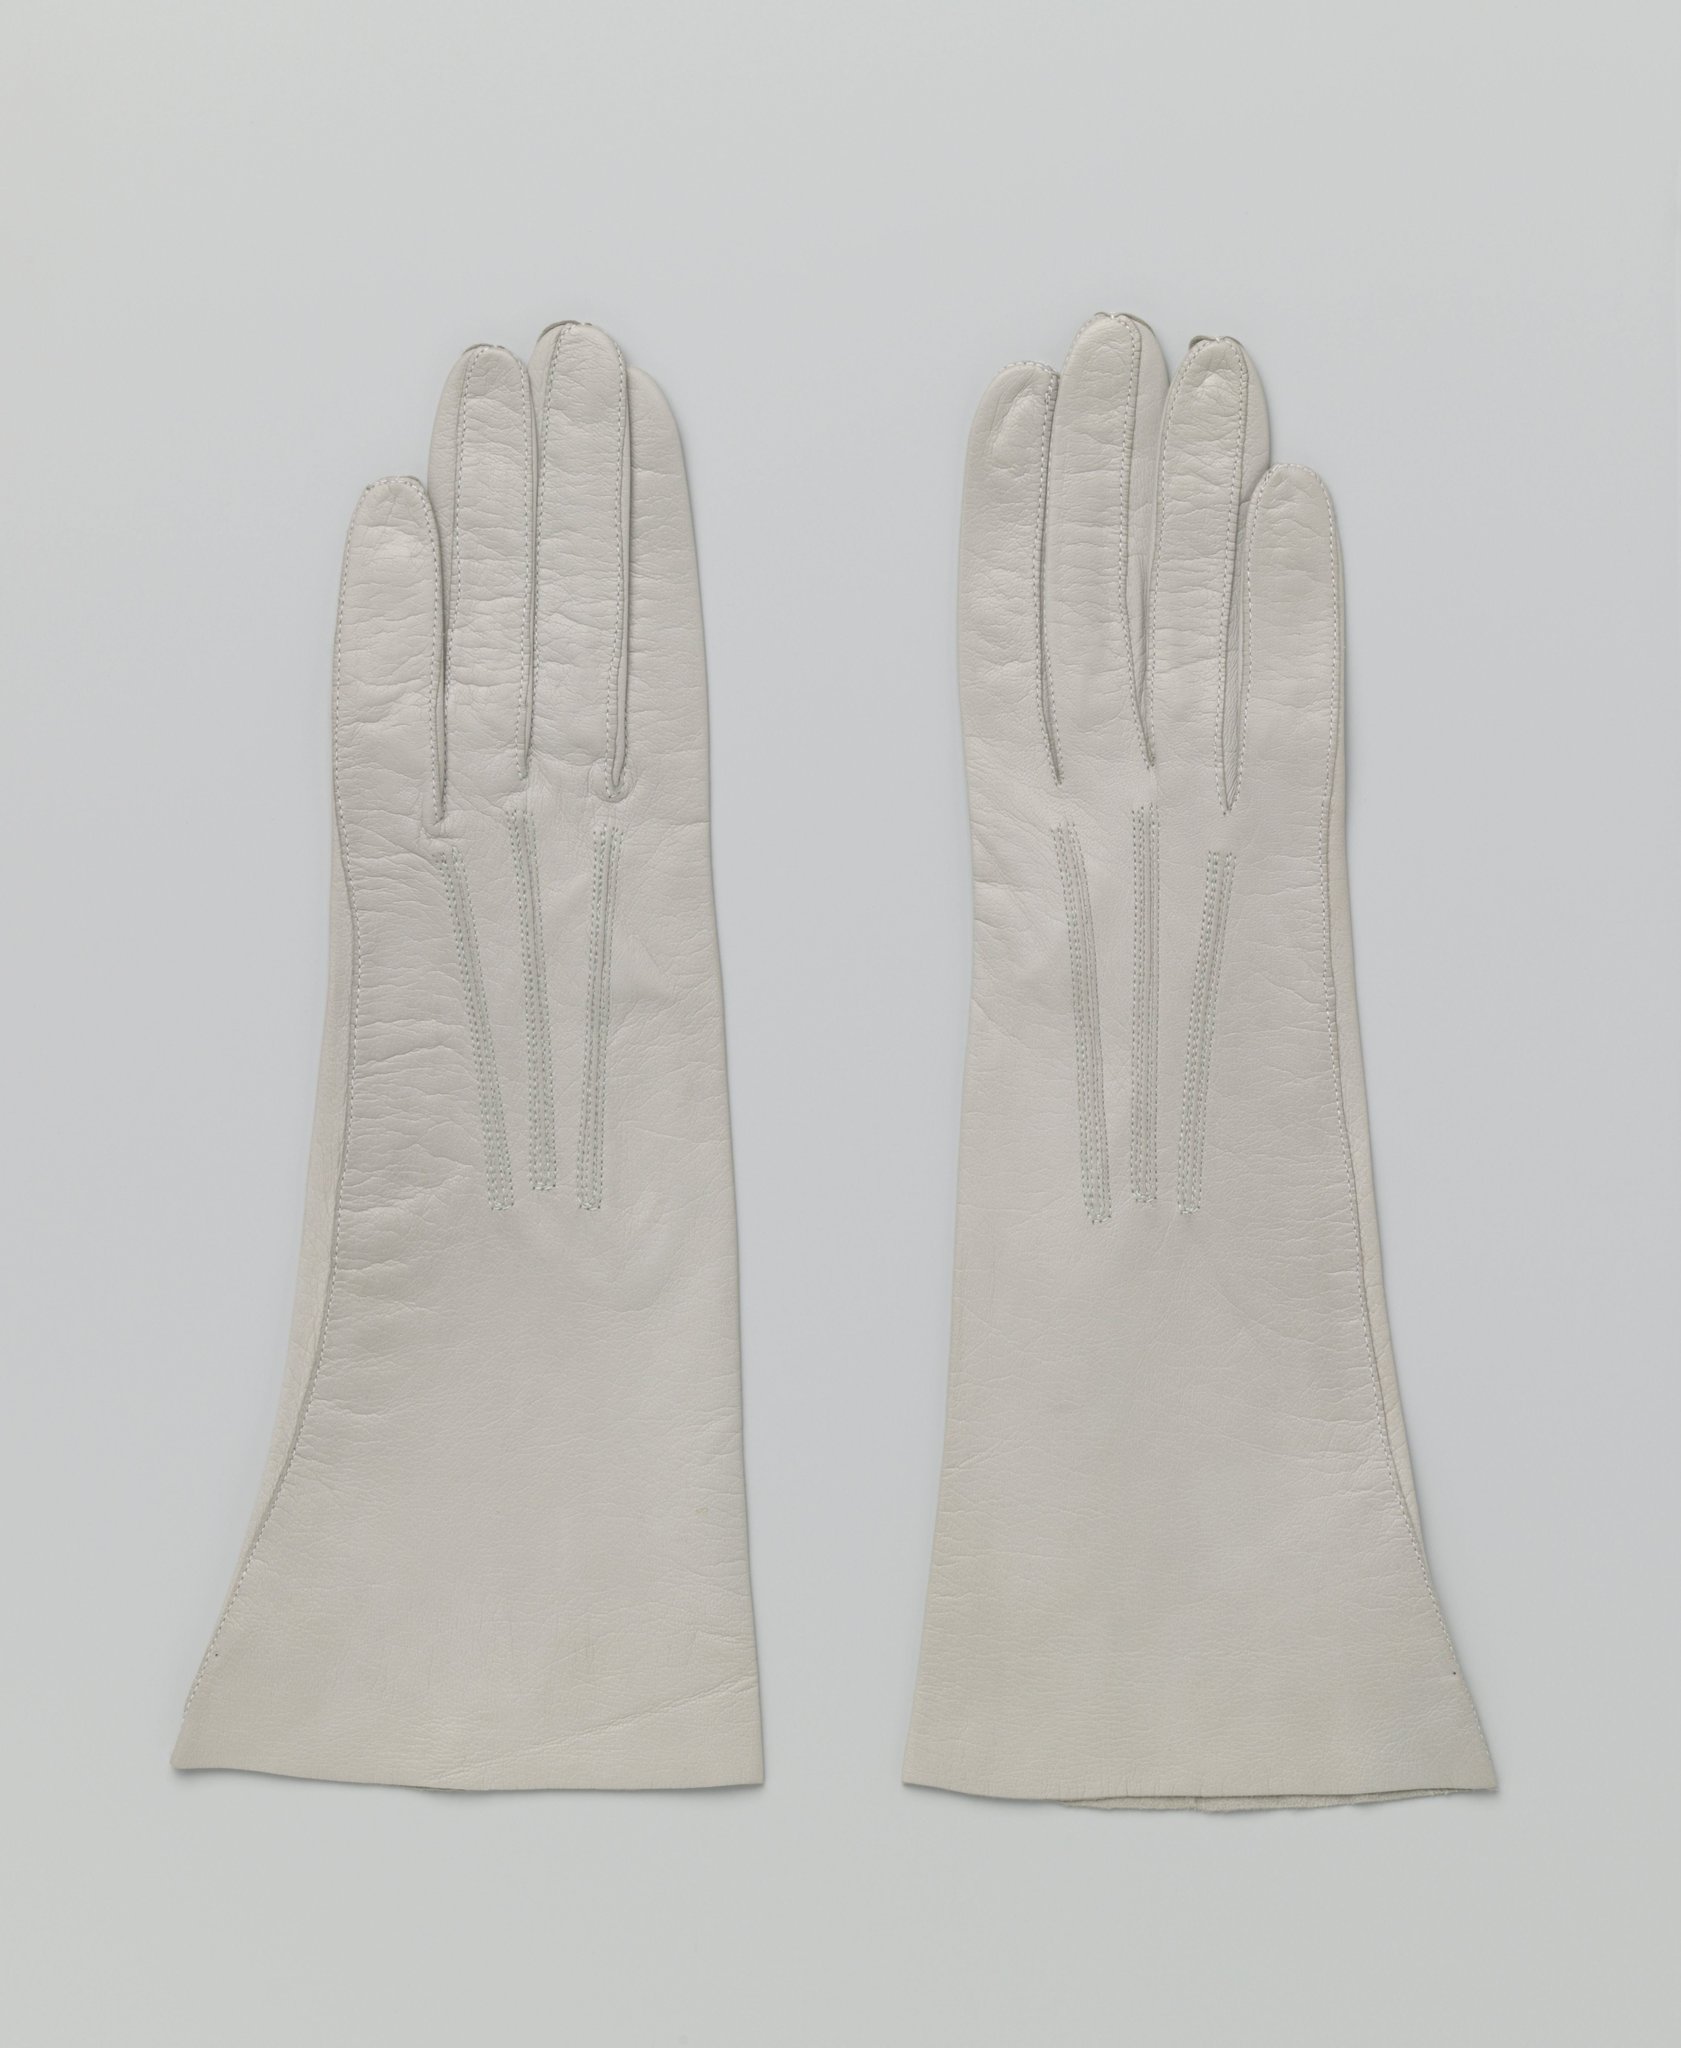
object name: clothing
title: Handschoen van grijs leer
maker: Anonymous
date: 1950-1970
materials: leather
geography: france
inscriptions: stamp: ‘tekst’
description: Rechterhandschoen van grijs leer. Op de hand drie uitstralende koorden.